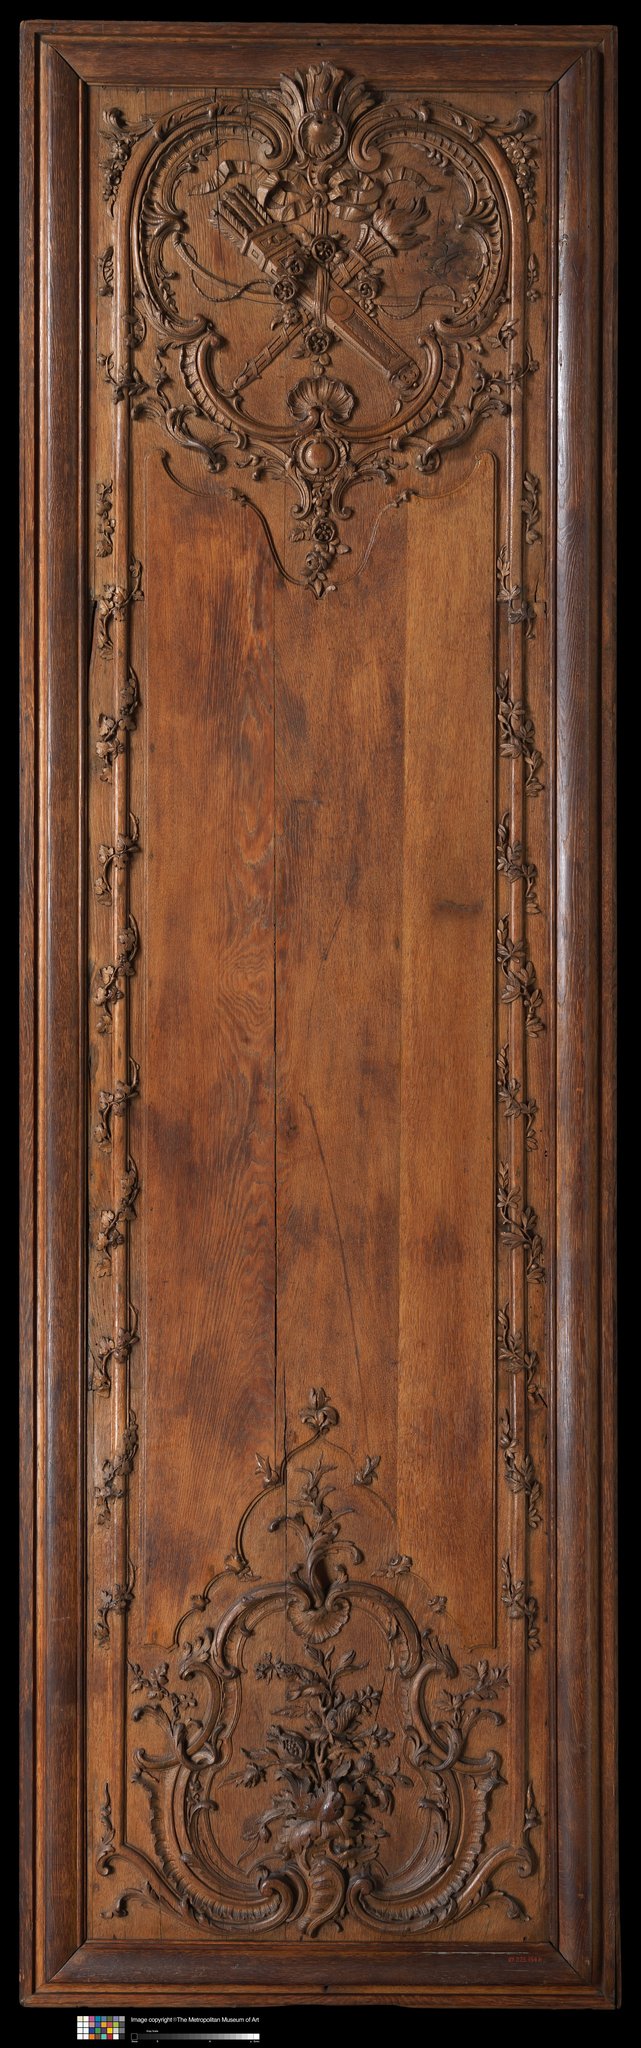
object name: panel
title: Panel with flaming torch, bow and quiver (one of a pair)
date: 1730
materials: wood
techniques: carving